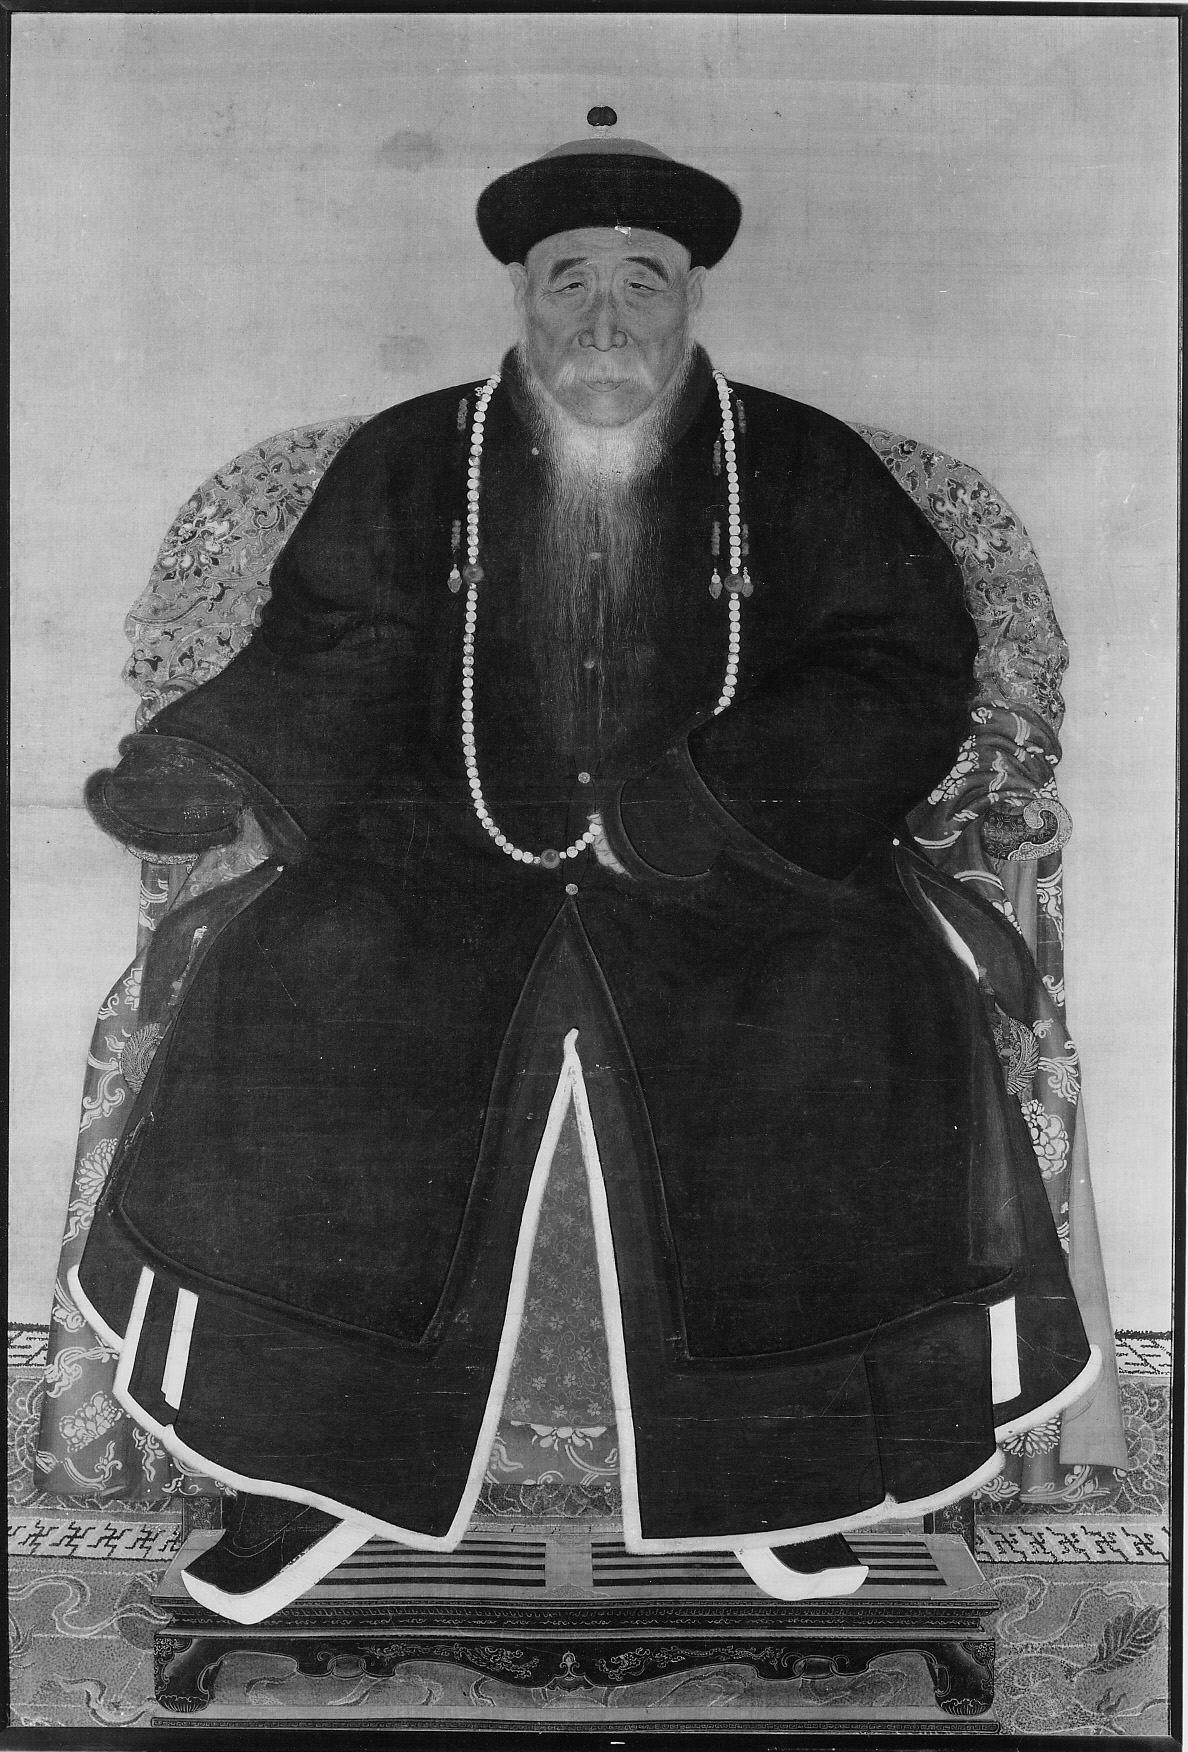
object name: painting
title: Portrait of a Manchu Official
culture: chinese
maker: unidentified artist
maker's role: artist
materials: ink, silk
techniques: painting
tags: men,portraits